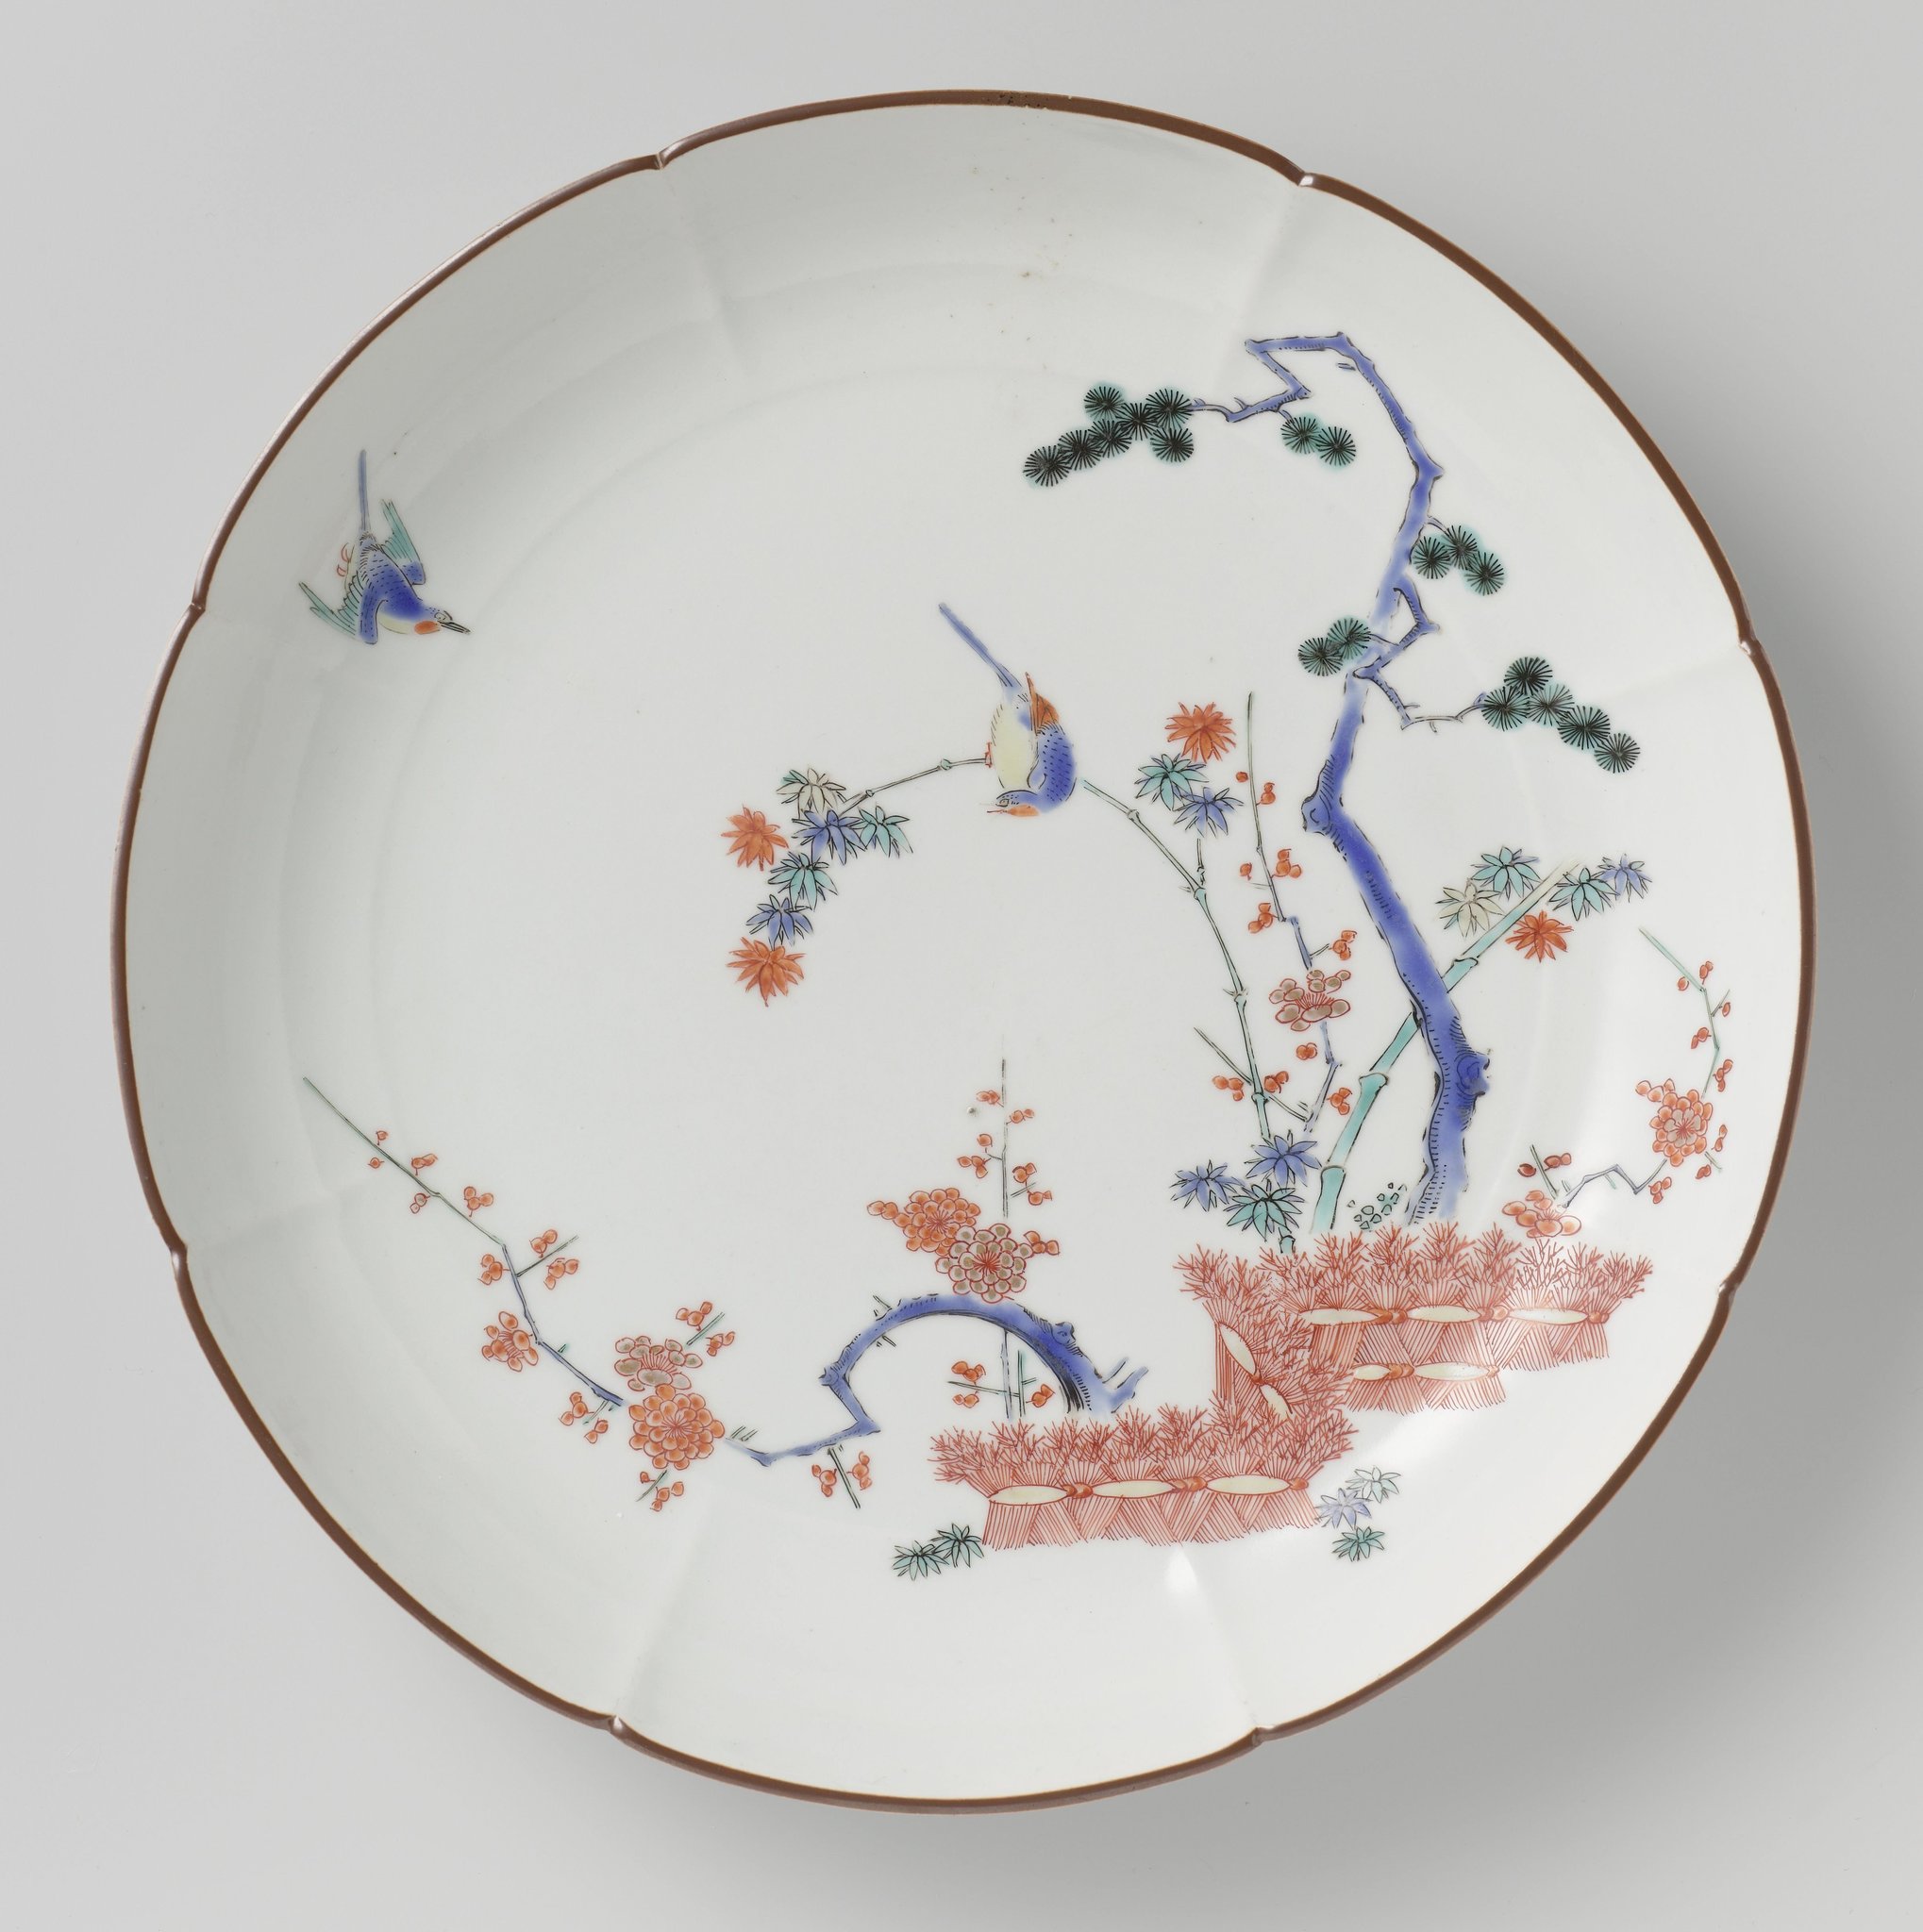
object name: plate dish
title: Plate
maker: Anonymous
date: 1670-1690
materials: glaze, gold, paint, porcelain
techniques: firing, gilding, turning, vitrification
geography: japan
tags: birds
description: Kakiemon ware was made between 1670 and 1690 in a highly distinctive style. The decoration is often asymmetric, leaving plenty of space for the white ground. The three sprays on this plate – from left to right, plum blossom, bamboo and pine (known as the ‘Three Friends of Winter’) – have been carefully arranged to achieve a balanced composition, despite the asymmetry.